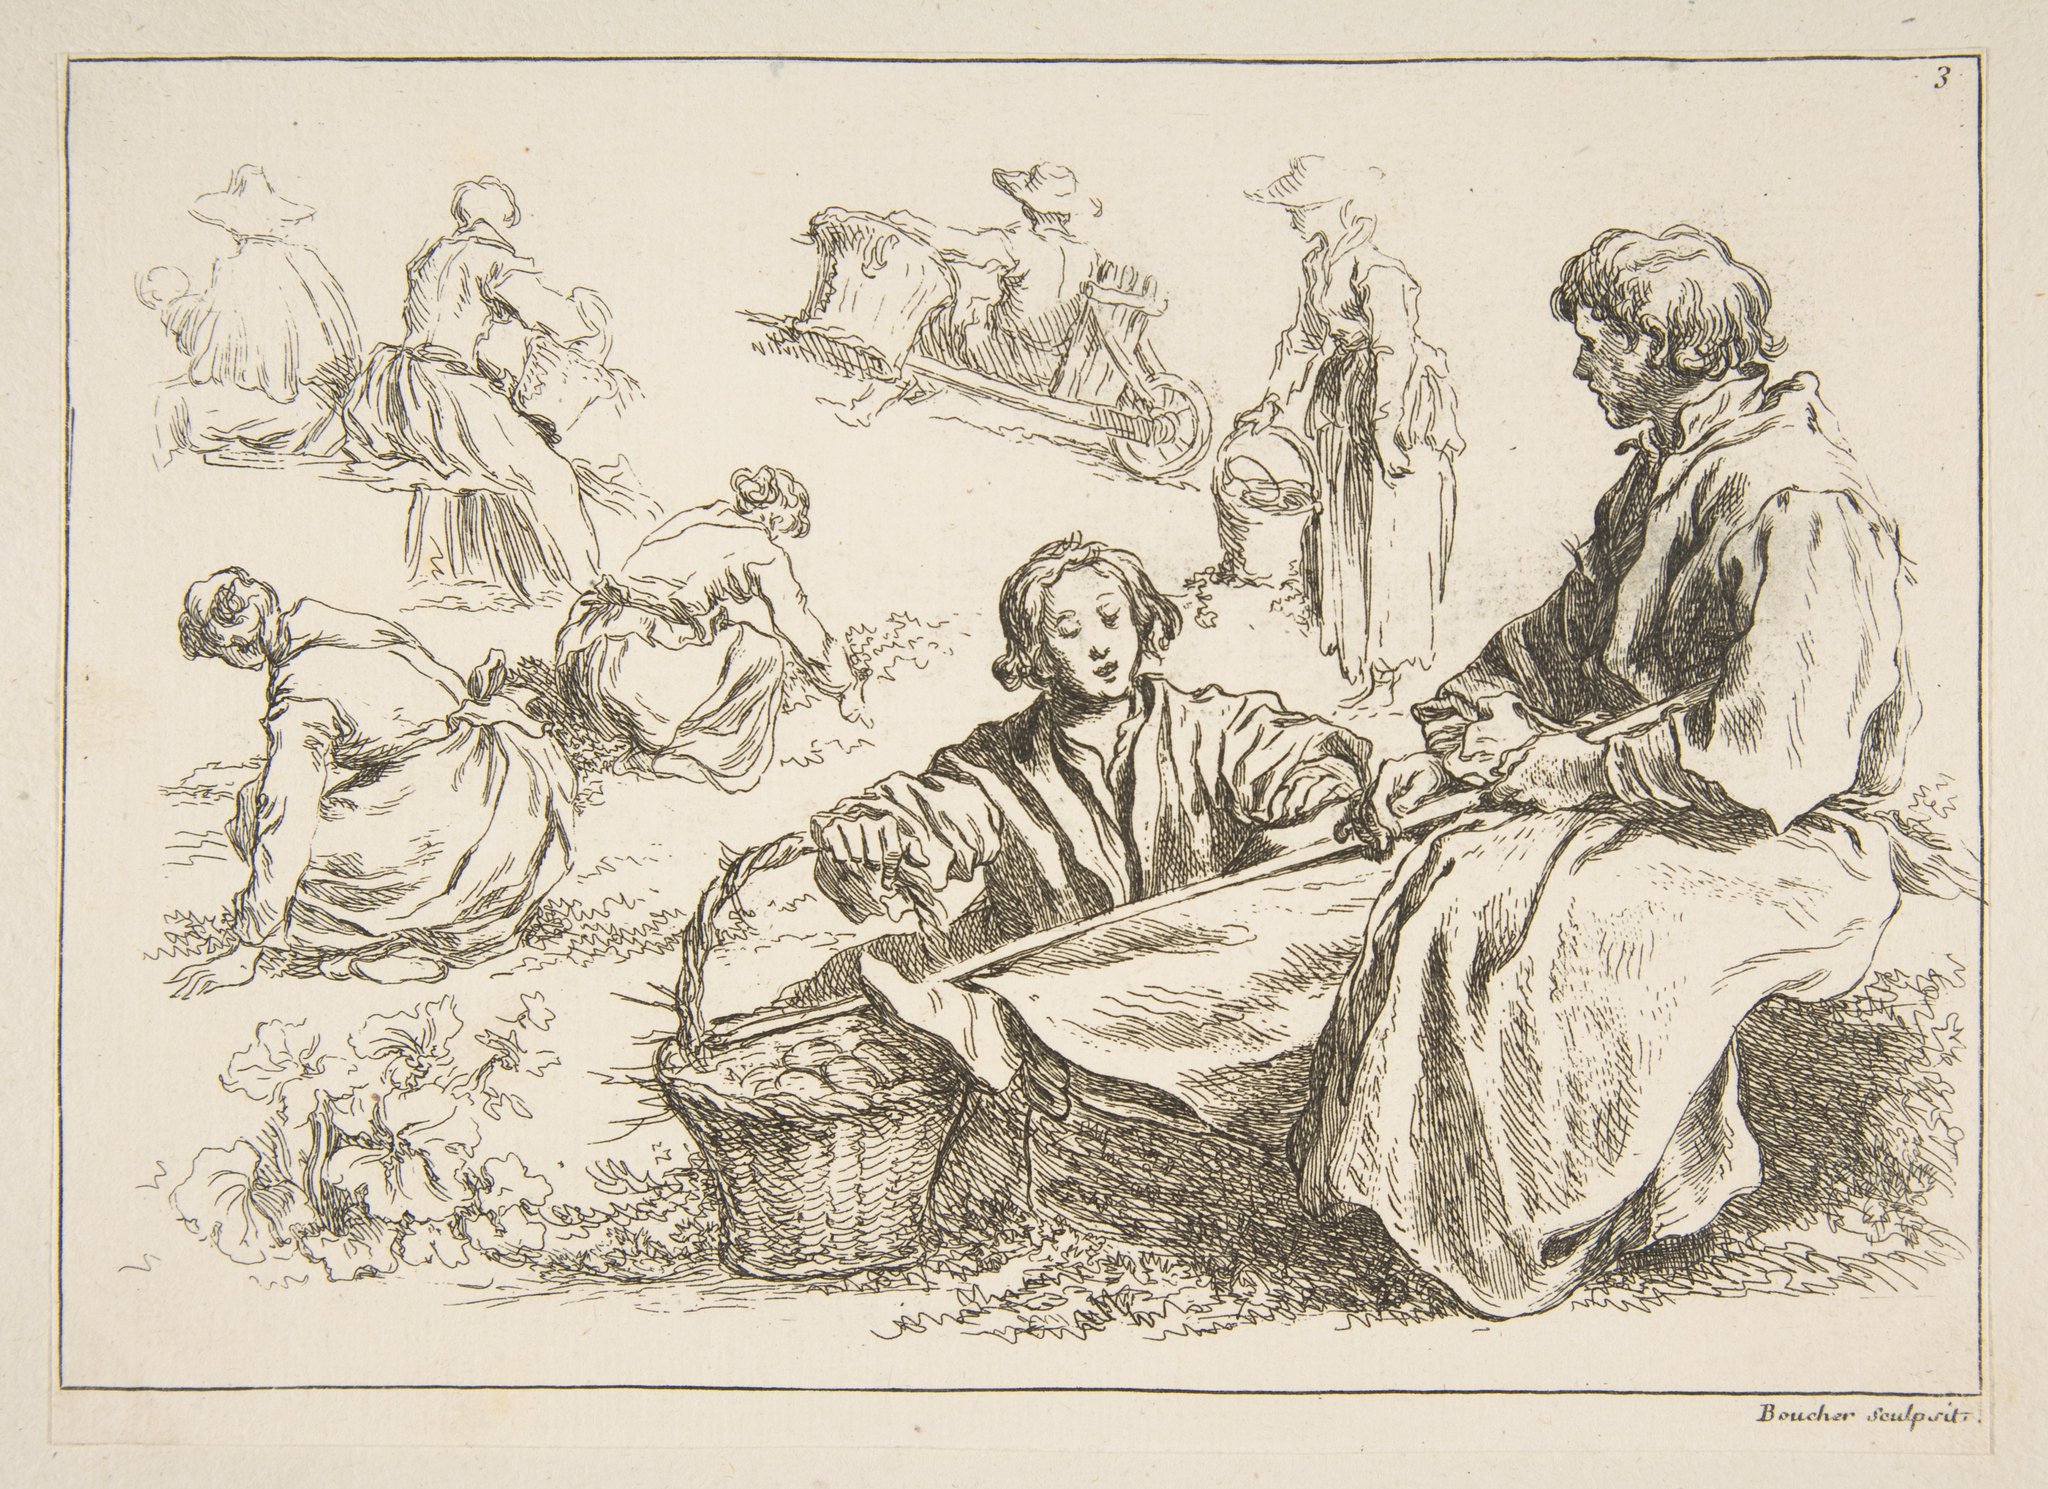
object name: print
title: Sheet of Sketches, from "Livre d’étude d’après les desseins originaux de Blomart"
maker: françois boucher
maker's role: artist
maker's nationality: french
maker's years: 1703-1770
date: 1735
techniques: etching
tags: women,working